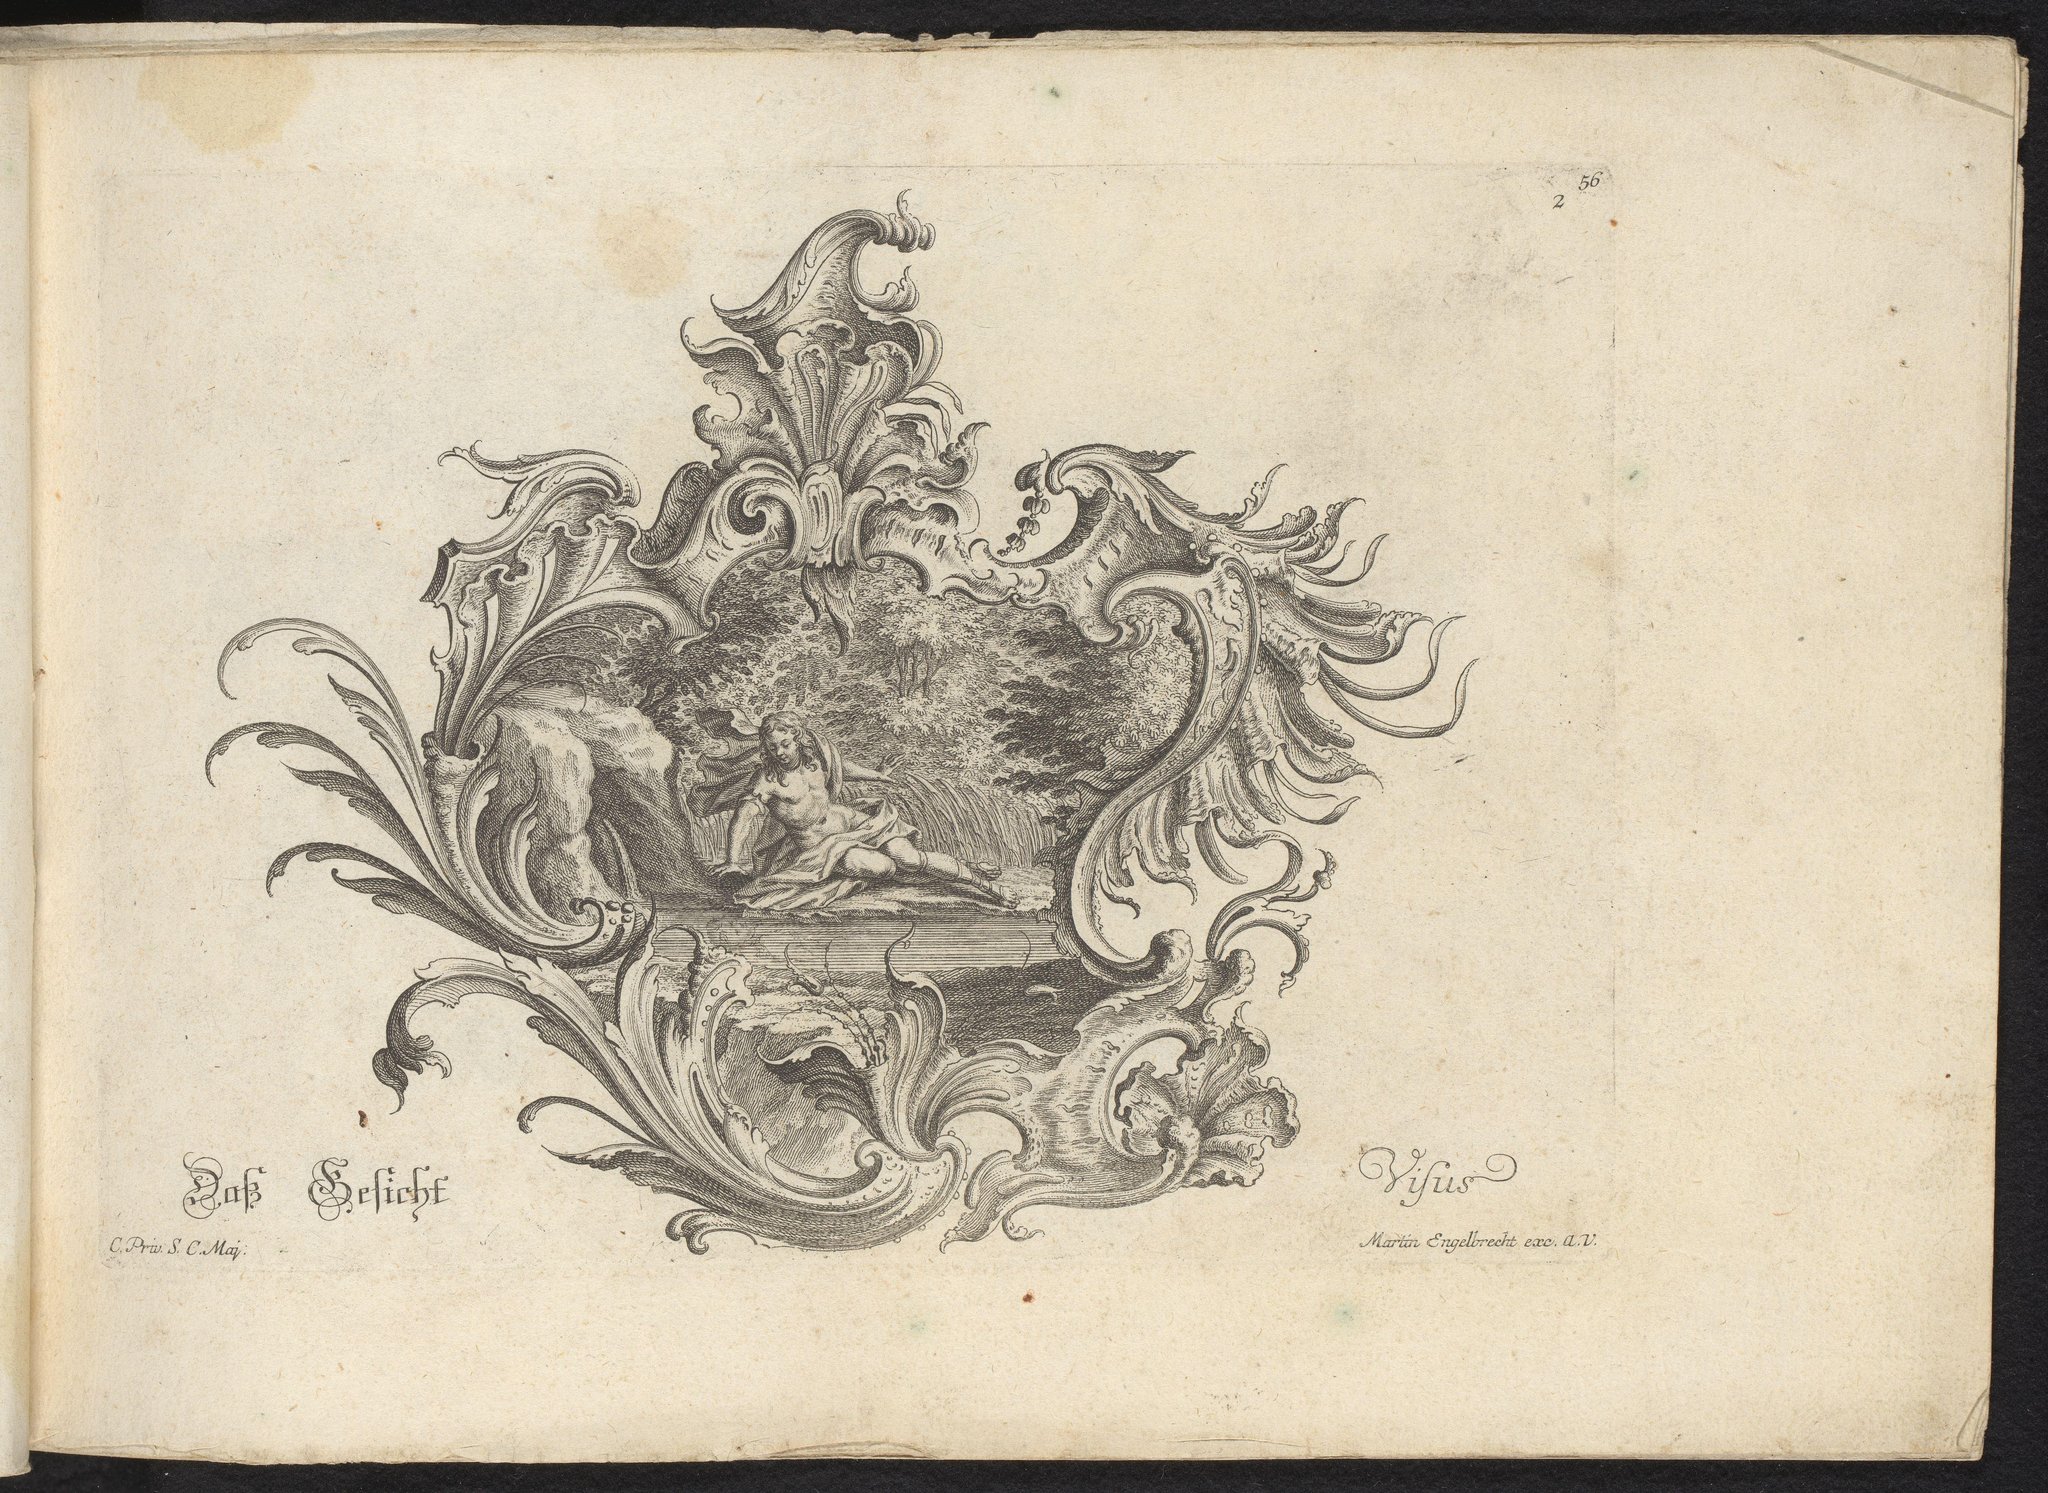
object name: print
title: Neu Inventierte auf die artigste Facon Sehr nutzliche Schild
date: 1712-1755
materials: paper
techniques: etching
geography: augsburg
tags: sight, looking (one of the five senses), (story of) narcissus, ornament ~ cartouche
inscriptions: collector's mark: Lugt 2228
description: Rocaille cartouche met een scène van Narcissus in een boslandschap die naar zijn eigen spiegelbeeld in het water kijkt. Prentnummer 56.